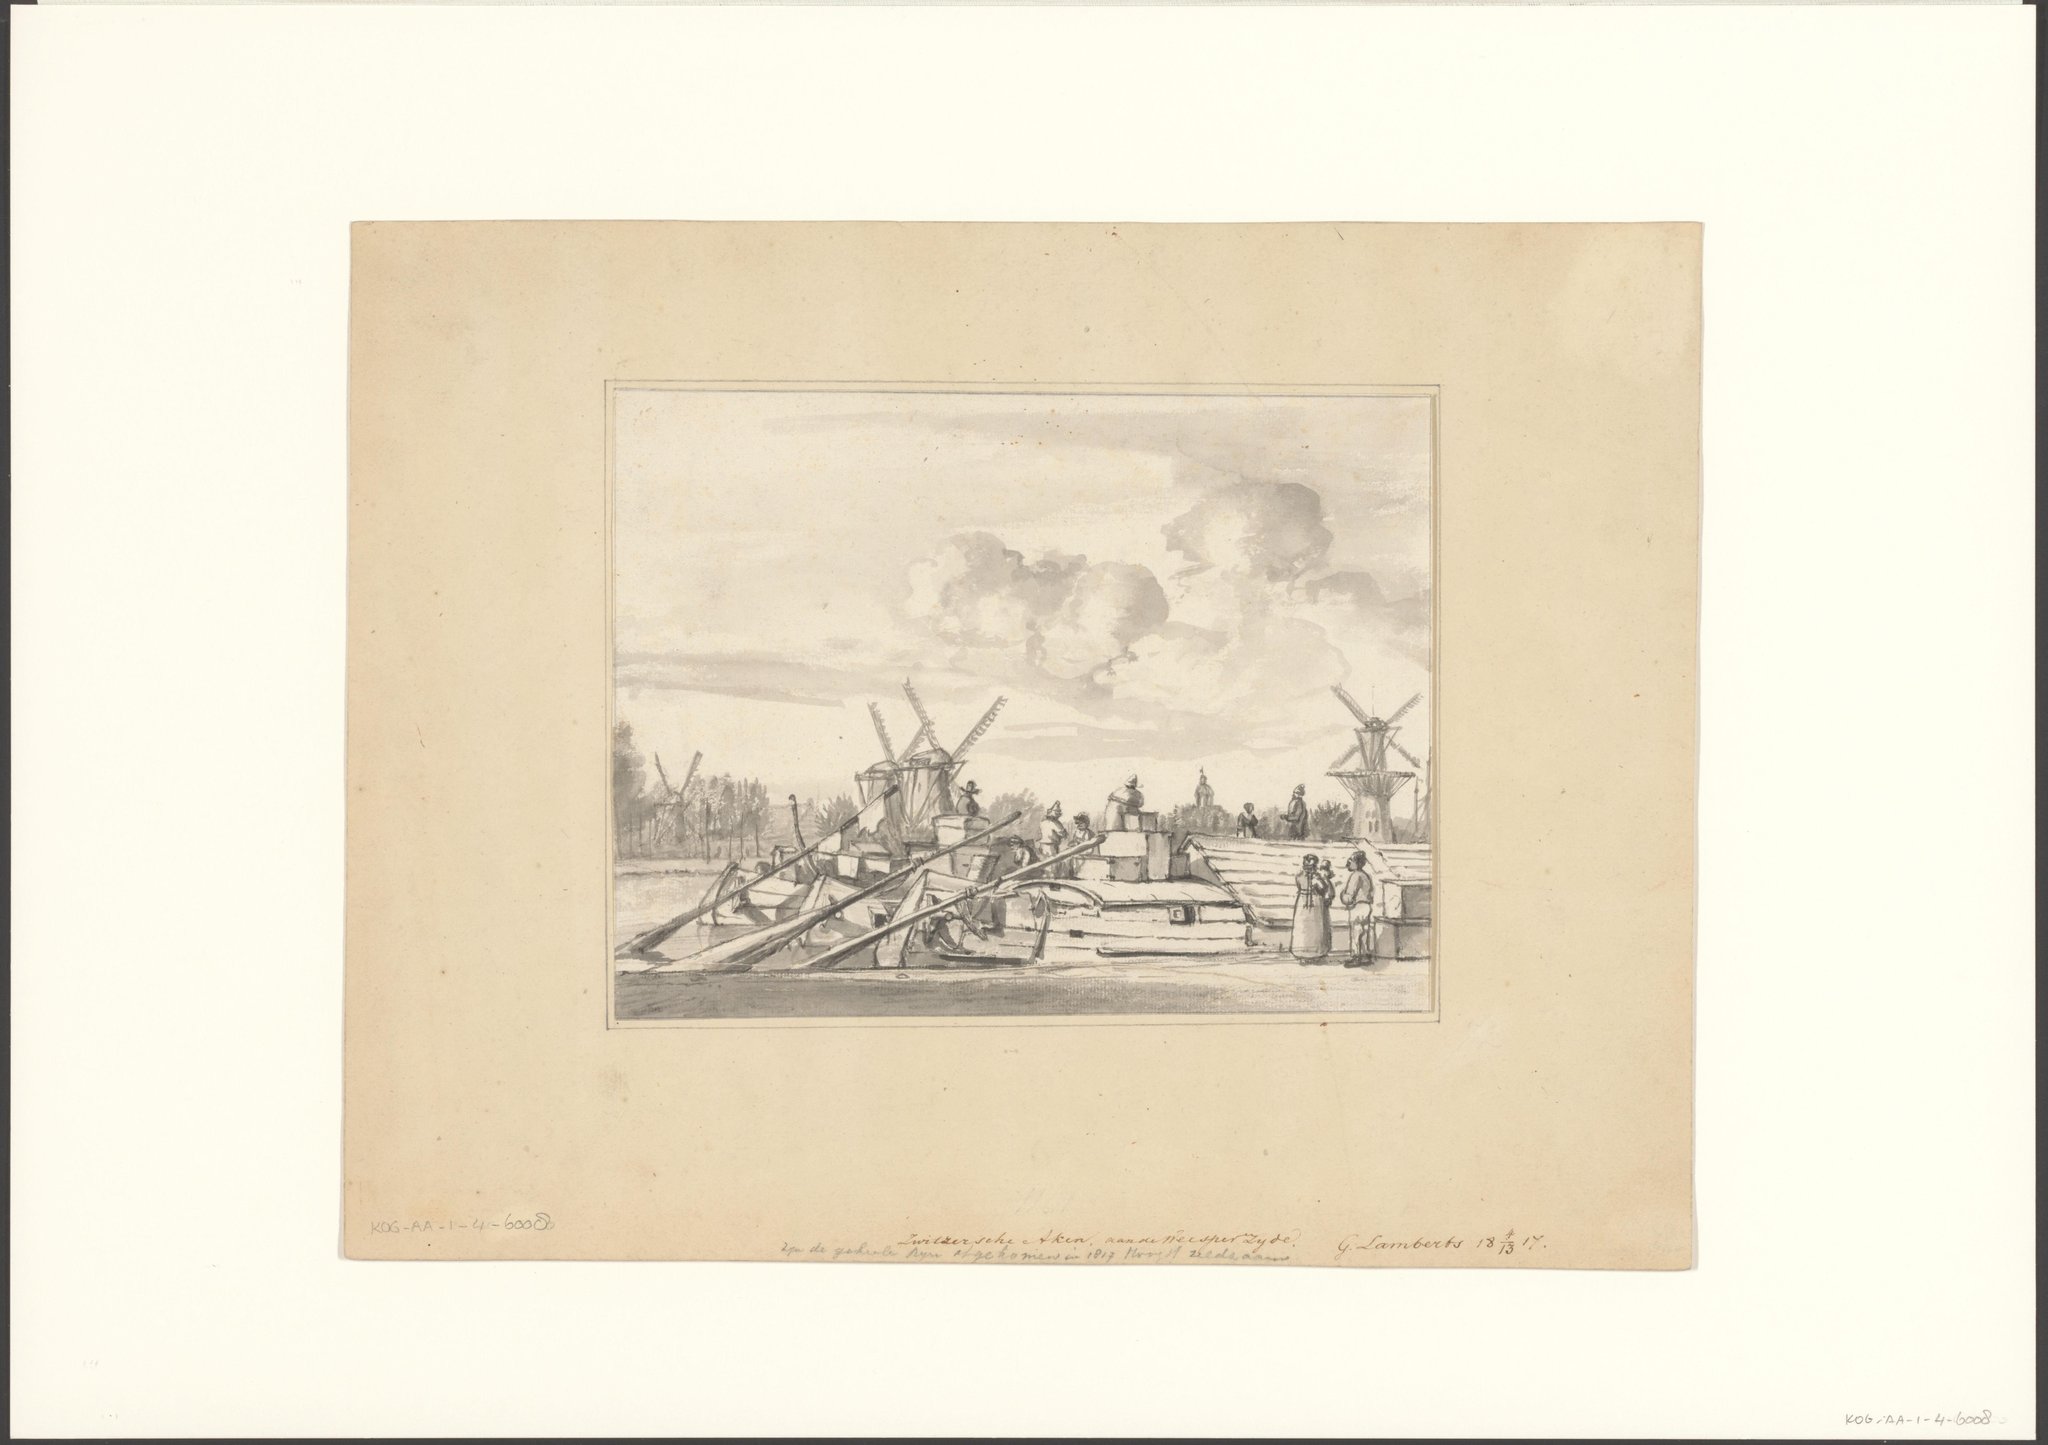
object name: drawing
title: Gezicht op de Weesperzijde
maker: gerrit lamberts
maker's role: bookseller, draughtsman, print maker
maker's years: 1776-1850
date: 1817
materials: chalk, ink, paper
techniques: brush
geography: amsterdam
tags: city-view in general; 'veduta', canal, windmill in landscape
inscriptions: inscription: ‘Zwitsersche Aken, aan de Weesperzijde. / G. Lamberts 18 4/13 17. / zijn de geheele [...] aangekomen in 1817 Hoogst zeldzaam’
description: Onderwerpsrubriek binnen de Atlas Amsterdam: Amstel van Hogesluis stroomopwaarts.